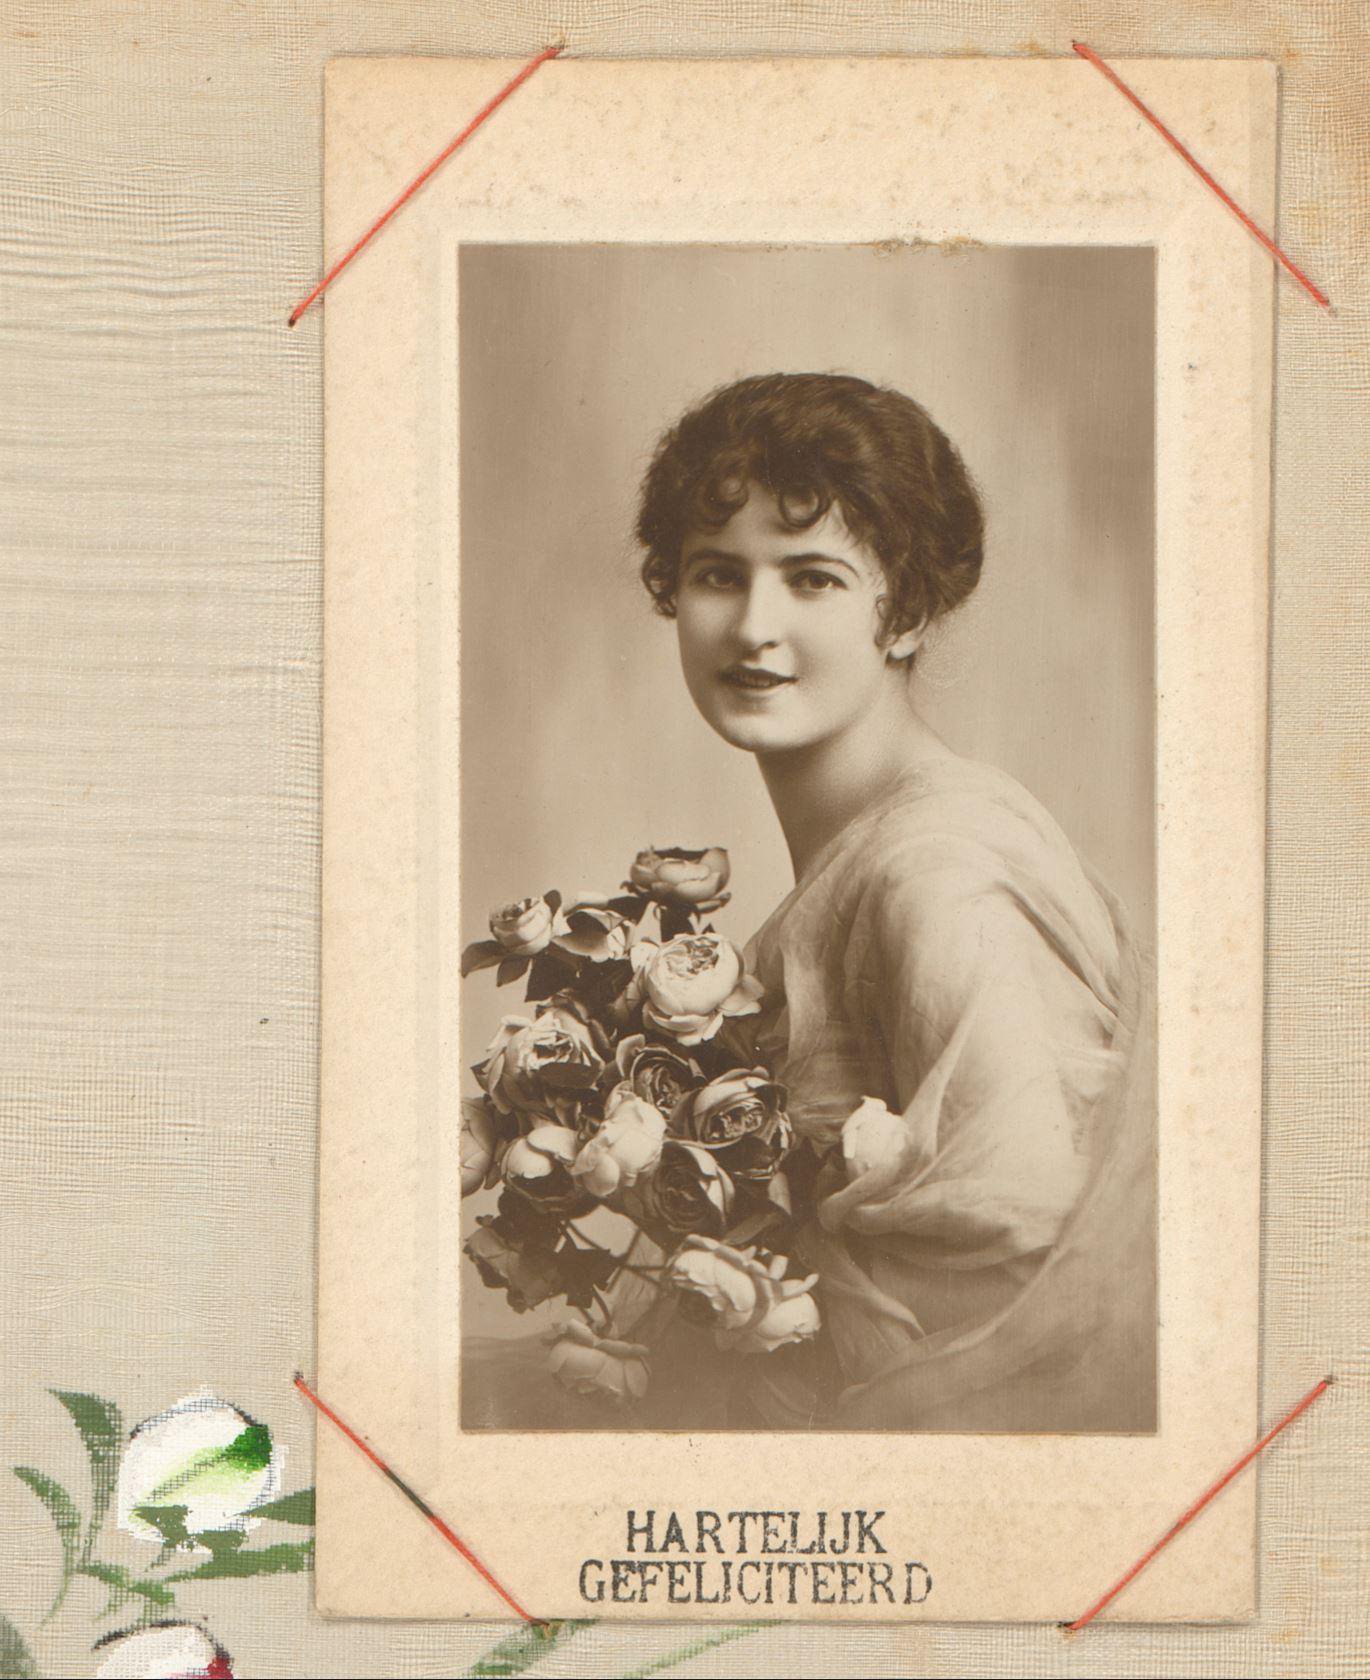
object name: photograph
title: Portret van een vrouw met bloemen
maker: Anonymous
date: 1880-1920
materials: paint, photographic support, silk, textile, watercolor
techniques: brush, gelatin silver print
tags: flowers, adult woman, historical persons